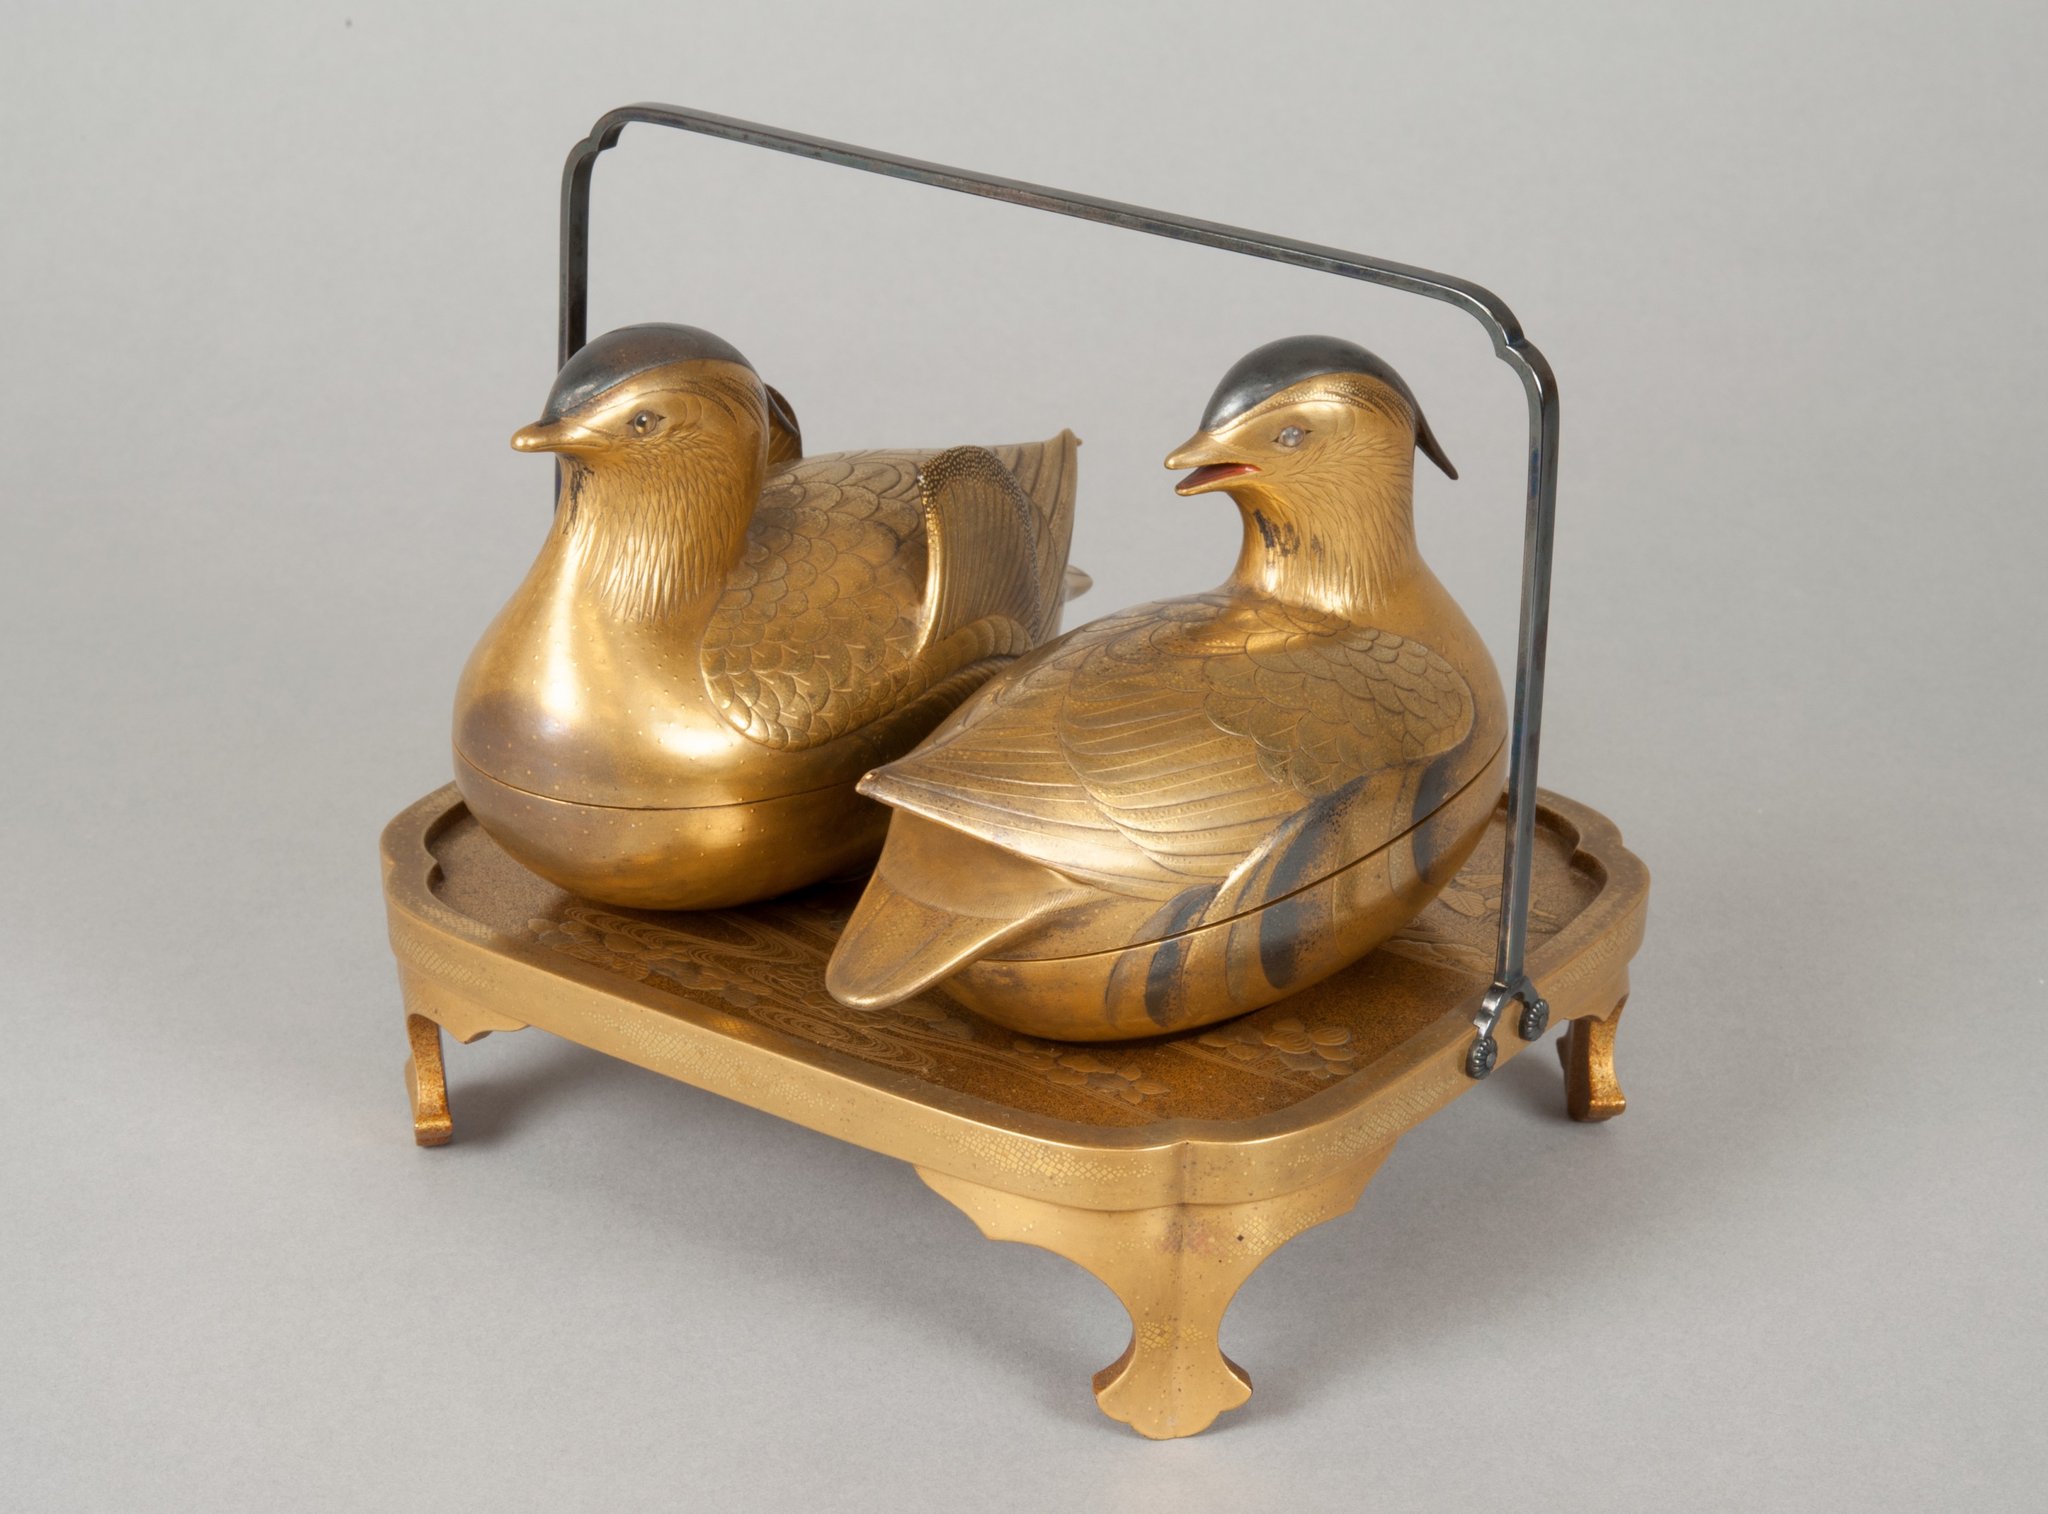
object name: incense box with tray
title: Pair of Incense Boxes (Kōgō) in the Shape of Mandarin Ducks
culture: japanese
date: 1851-1900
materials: gold, gold foil, silver, wood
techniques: hiramakie, lacquer, maki-e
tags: ducks